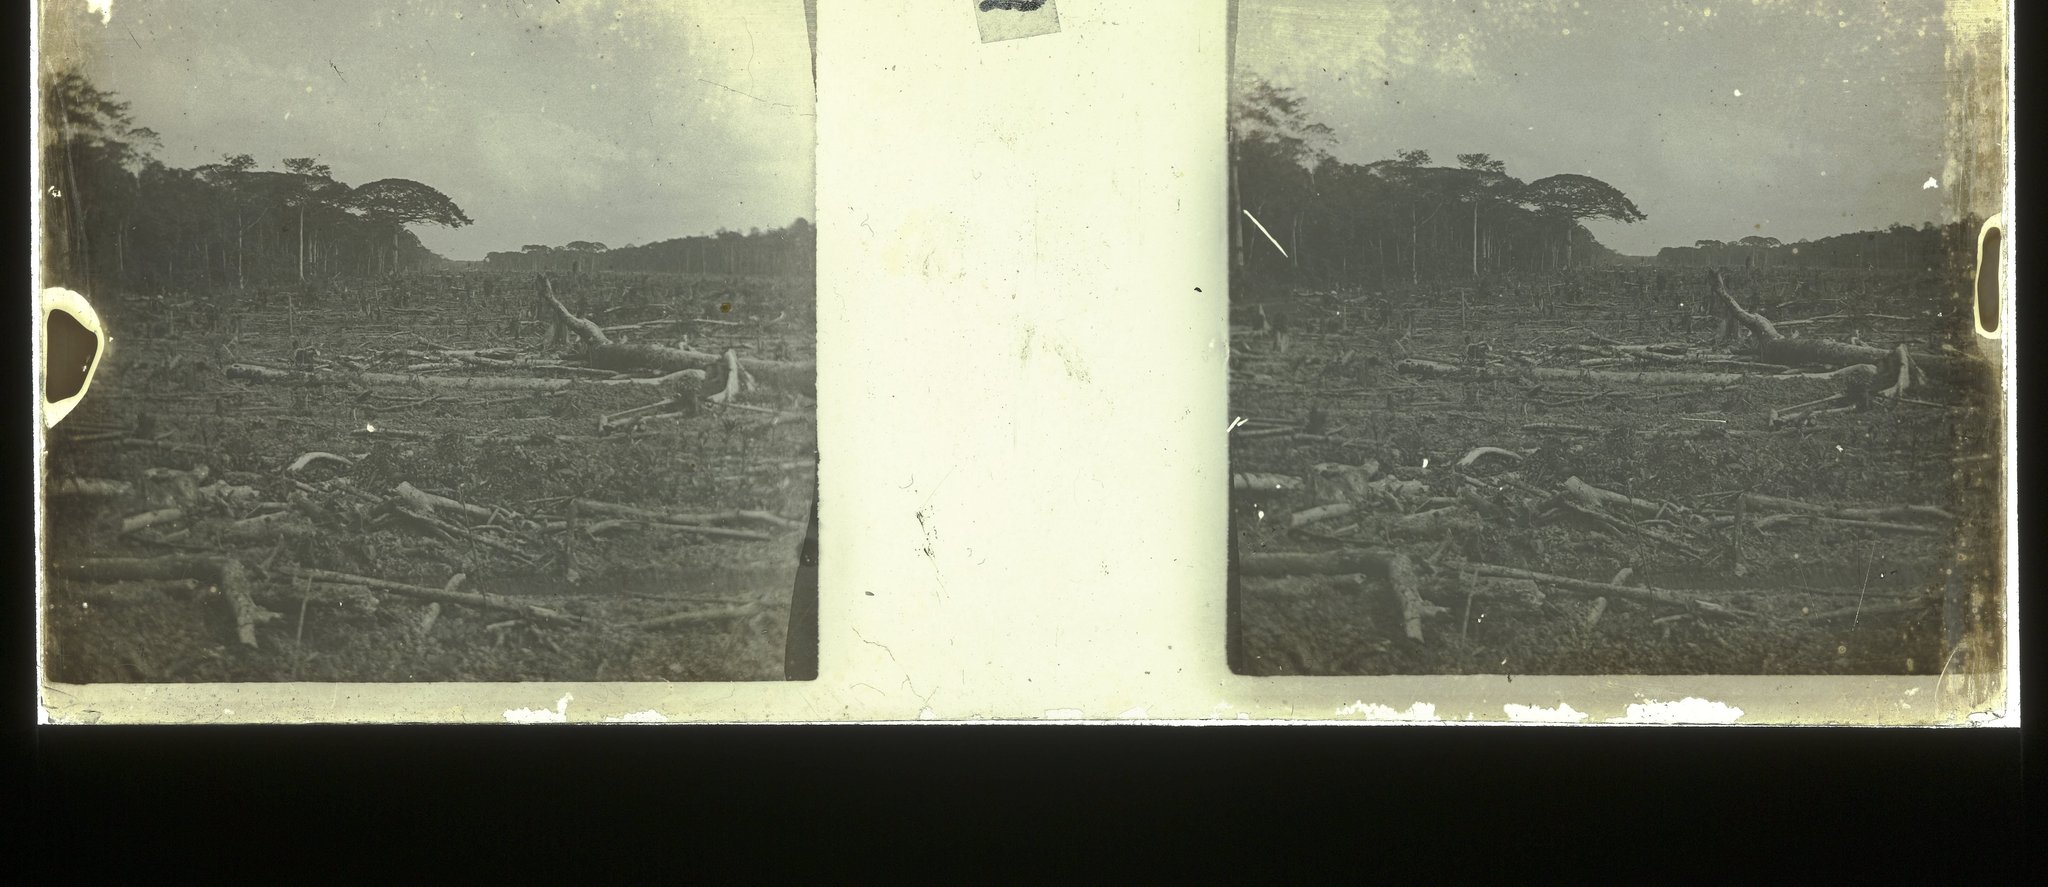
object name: stereograph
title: Houtkap op plantage Accaribo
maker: theodoor brouwers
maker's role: amateurfotograaf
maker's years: 1874-1932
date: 1913-1930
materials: glass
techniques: photography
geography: suriname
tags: amsterdam, theodoor brouwers, plantation, suriname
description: In de periode 1911-1932 woonde op plantage Accaribo in Suriname de familie Brouwers van wie de foto's afkomstig zijn. Rond 1910 vond Theodoor Brouwers werk op plantage Accaribo. In 1929 werd hij eigenaar van de plantage. Op Accaribo werden in zijn tijd bananen geproduceerd en wat koffie.